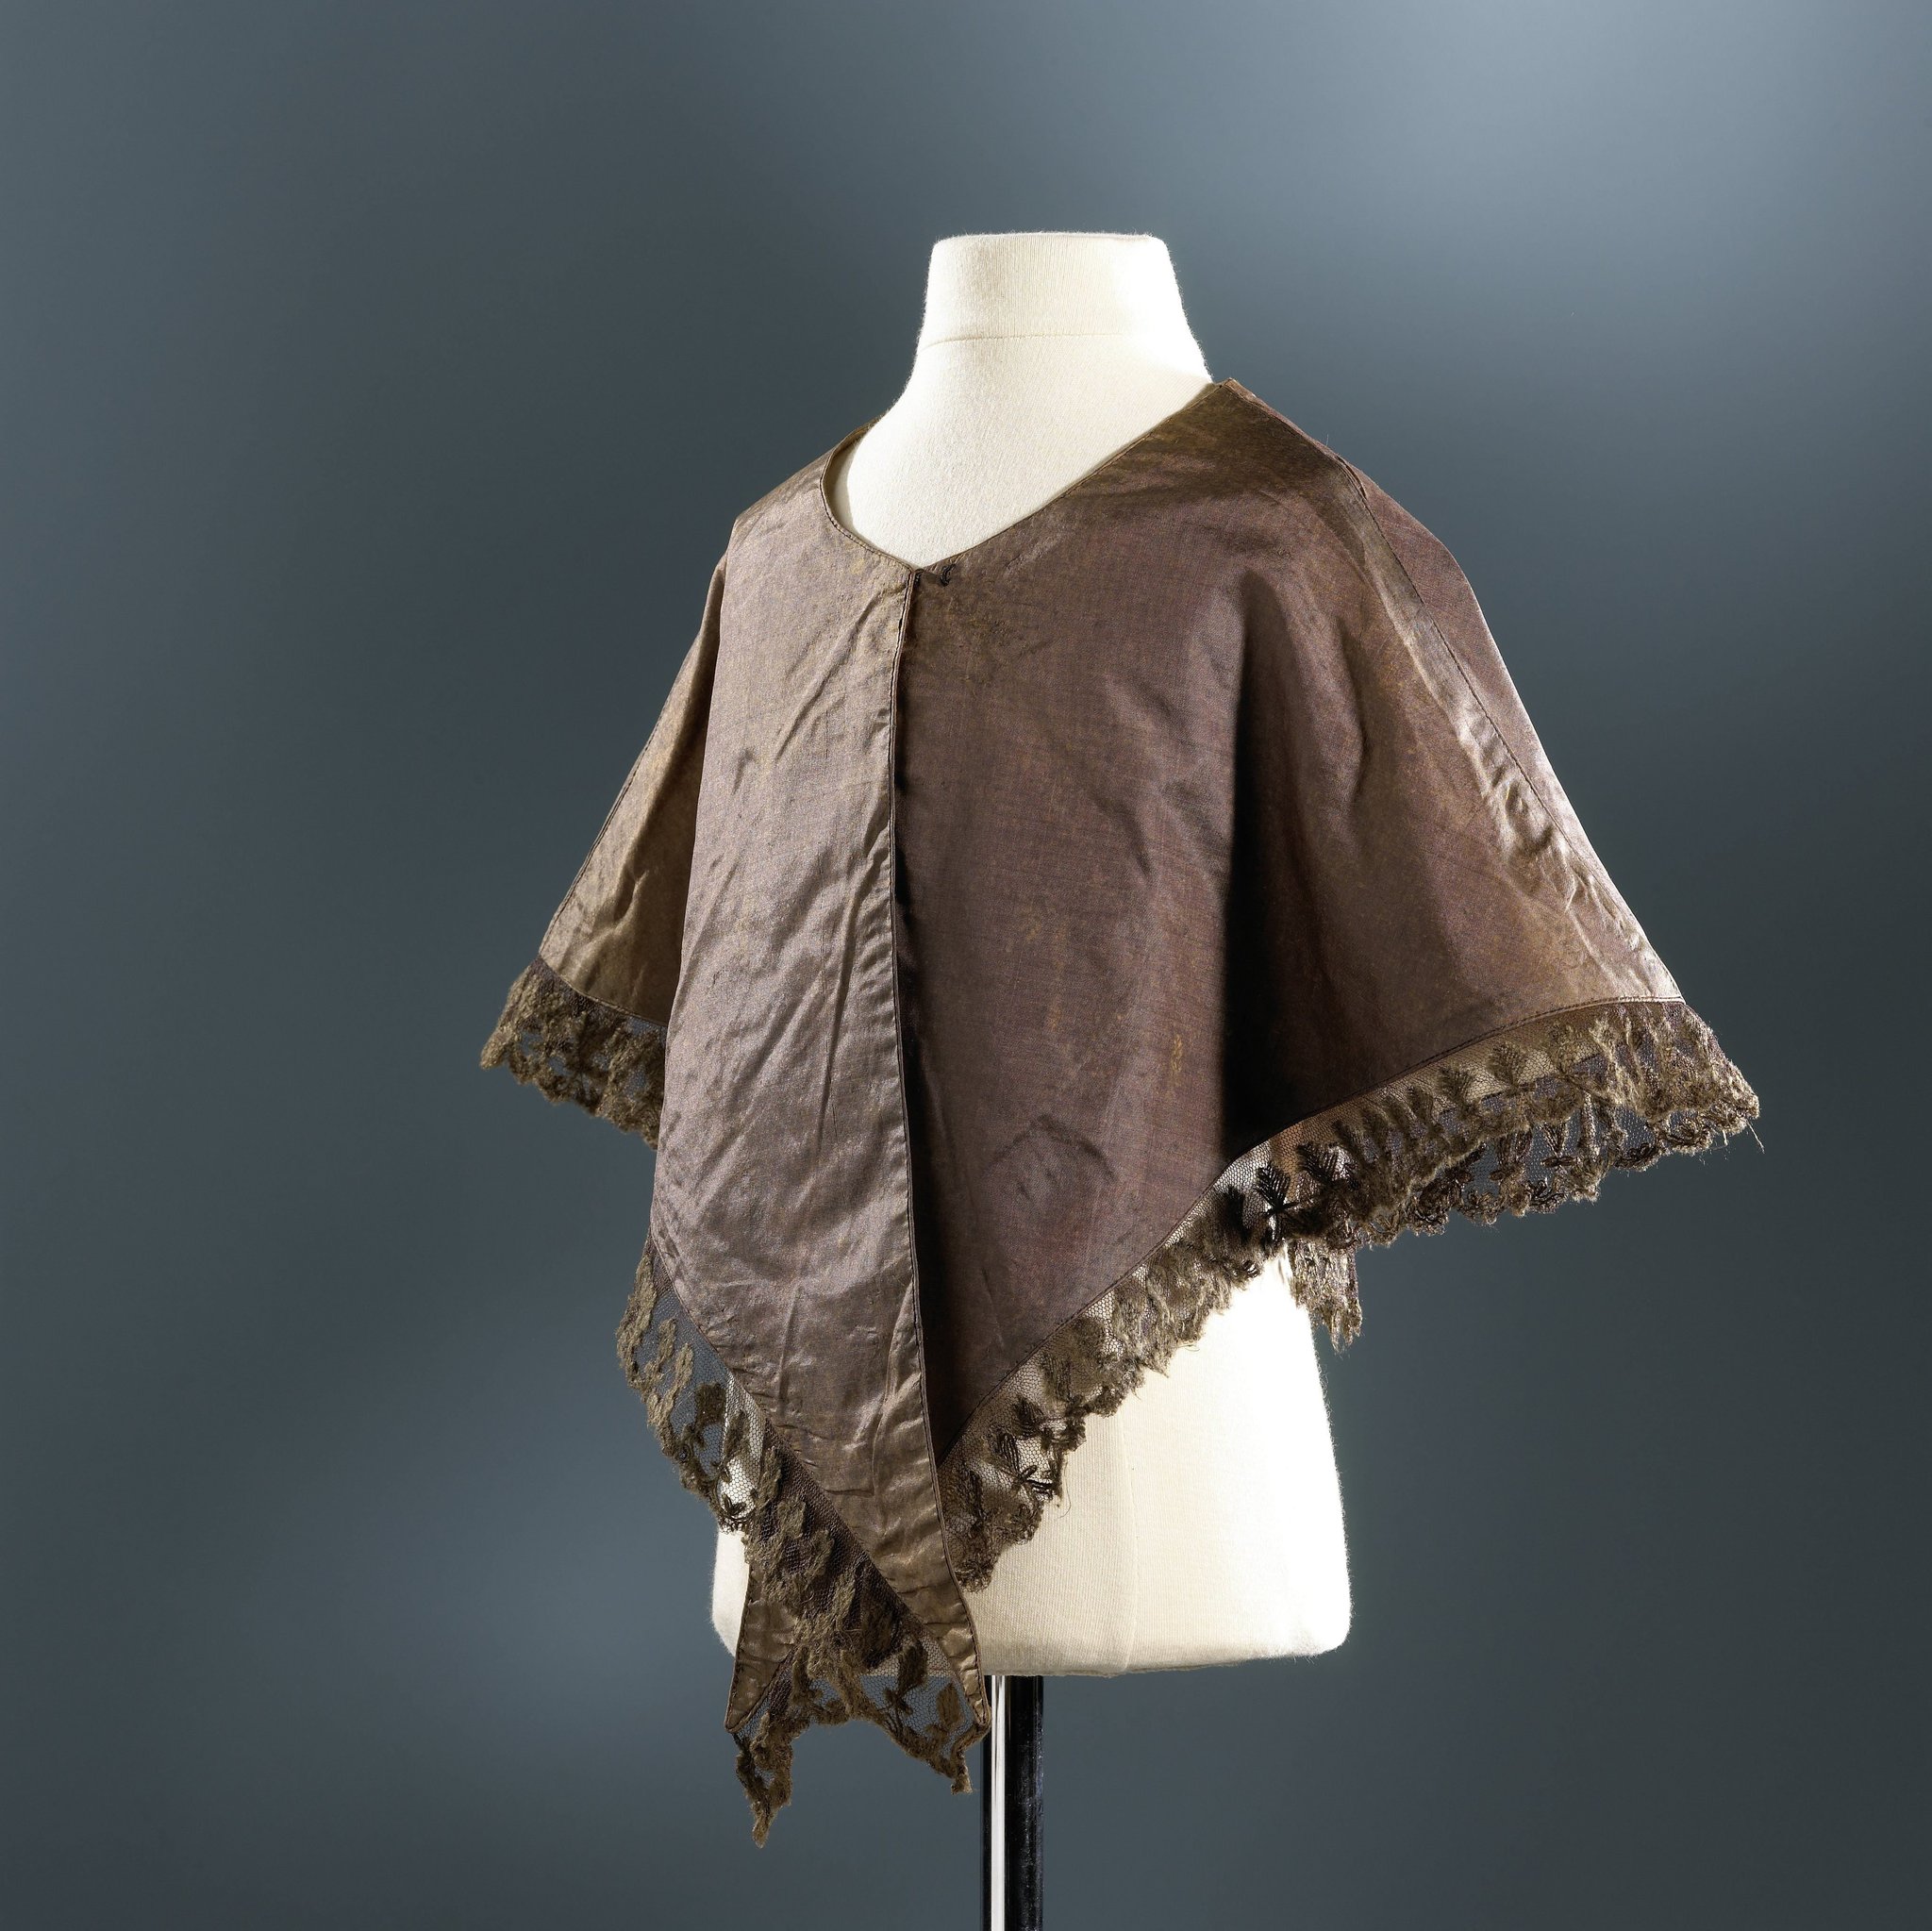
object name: childrenswear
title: Pelerine van bruine tafzijde afgezet met een strook bruine zijden tule doorstop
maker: Anonymous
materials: cotton, metal, silk, wool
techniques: casting, embroidered, weave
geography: netherlands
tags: trijntje van leyden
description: Trijnte van Leyden werd in 1855 geboren en overleed op 10-jarige leeftijd. Haar kleren en enkele persoonlijke bezittingen zijn - ter nagedachtenis aan haar voortijdig overlijden - bewaard gebleven en verefd. Trijntje's oudere zuster Guurtje was de grootmoeder van de schenkster, mevrouw Wilhelmina Buys. Van Leyden komt van haar moeders kant.